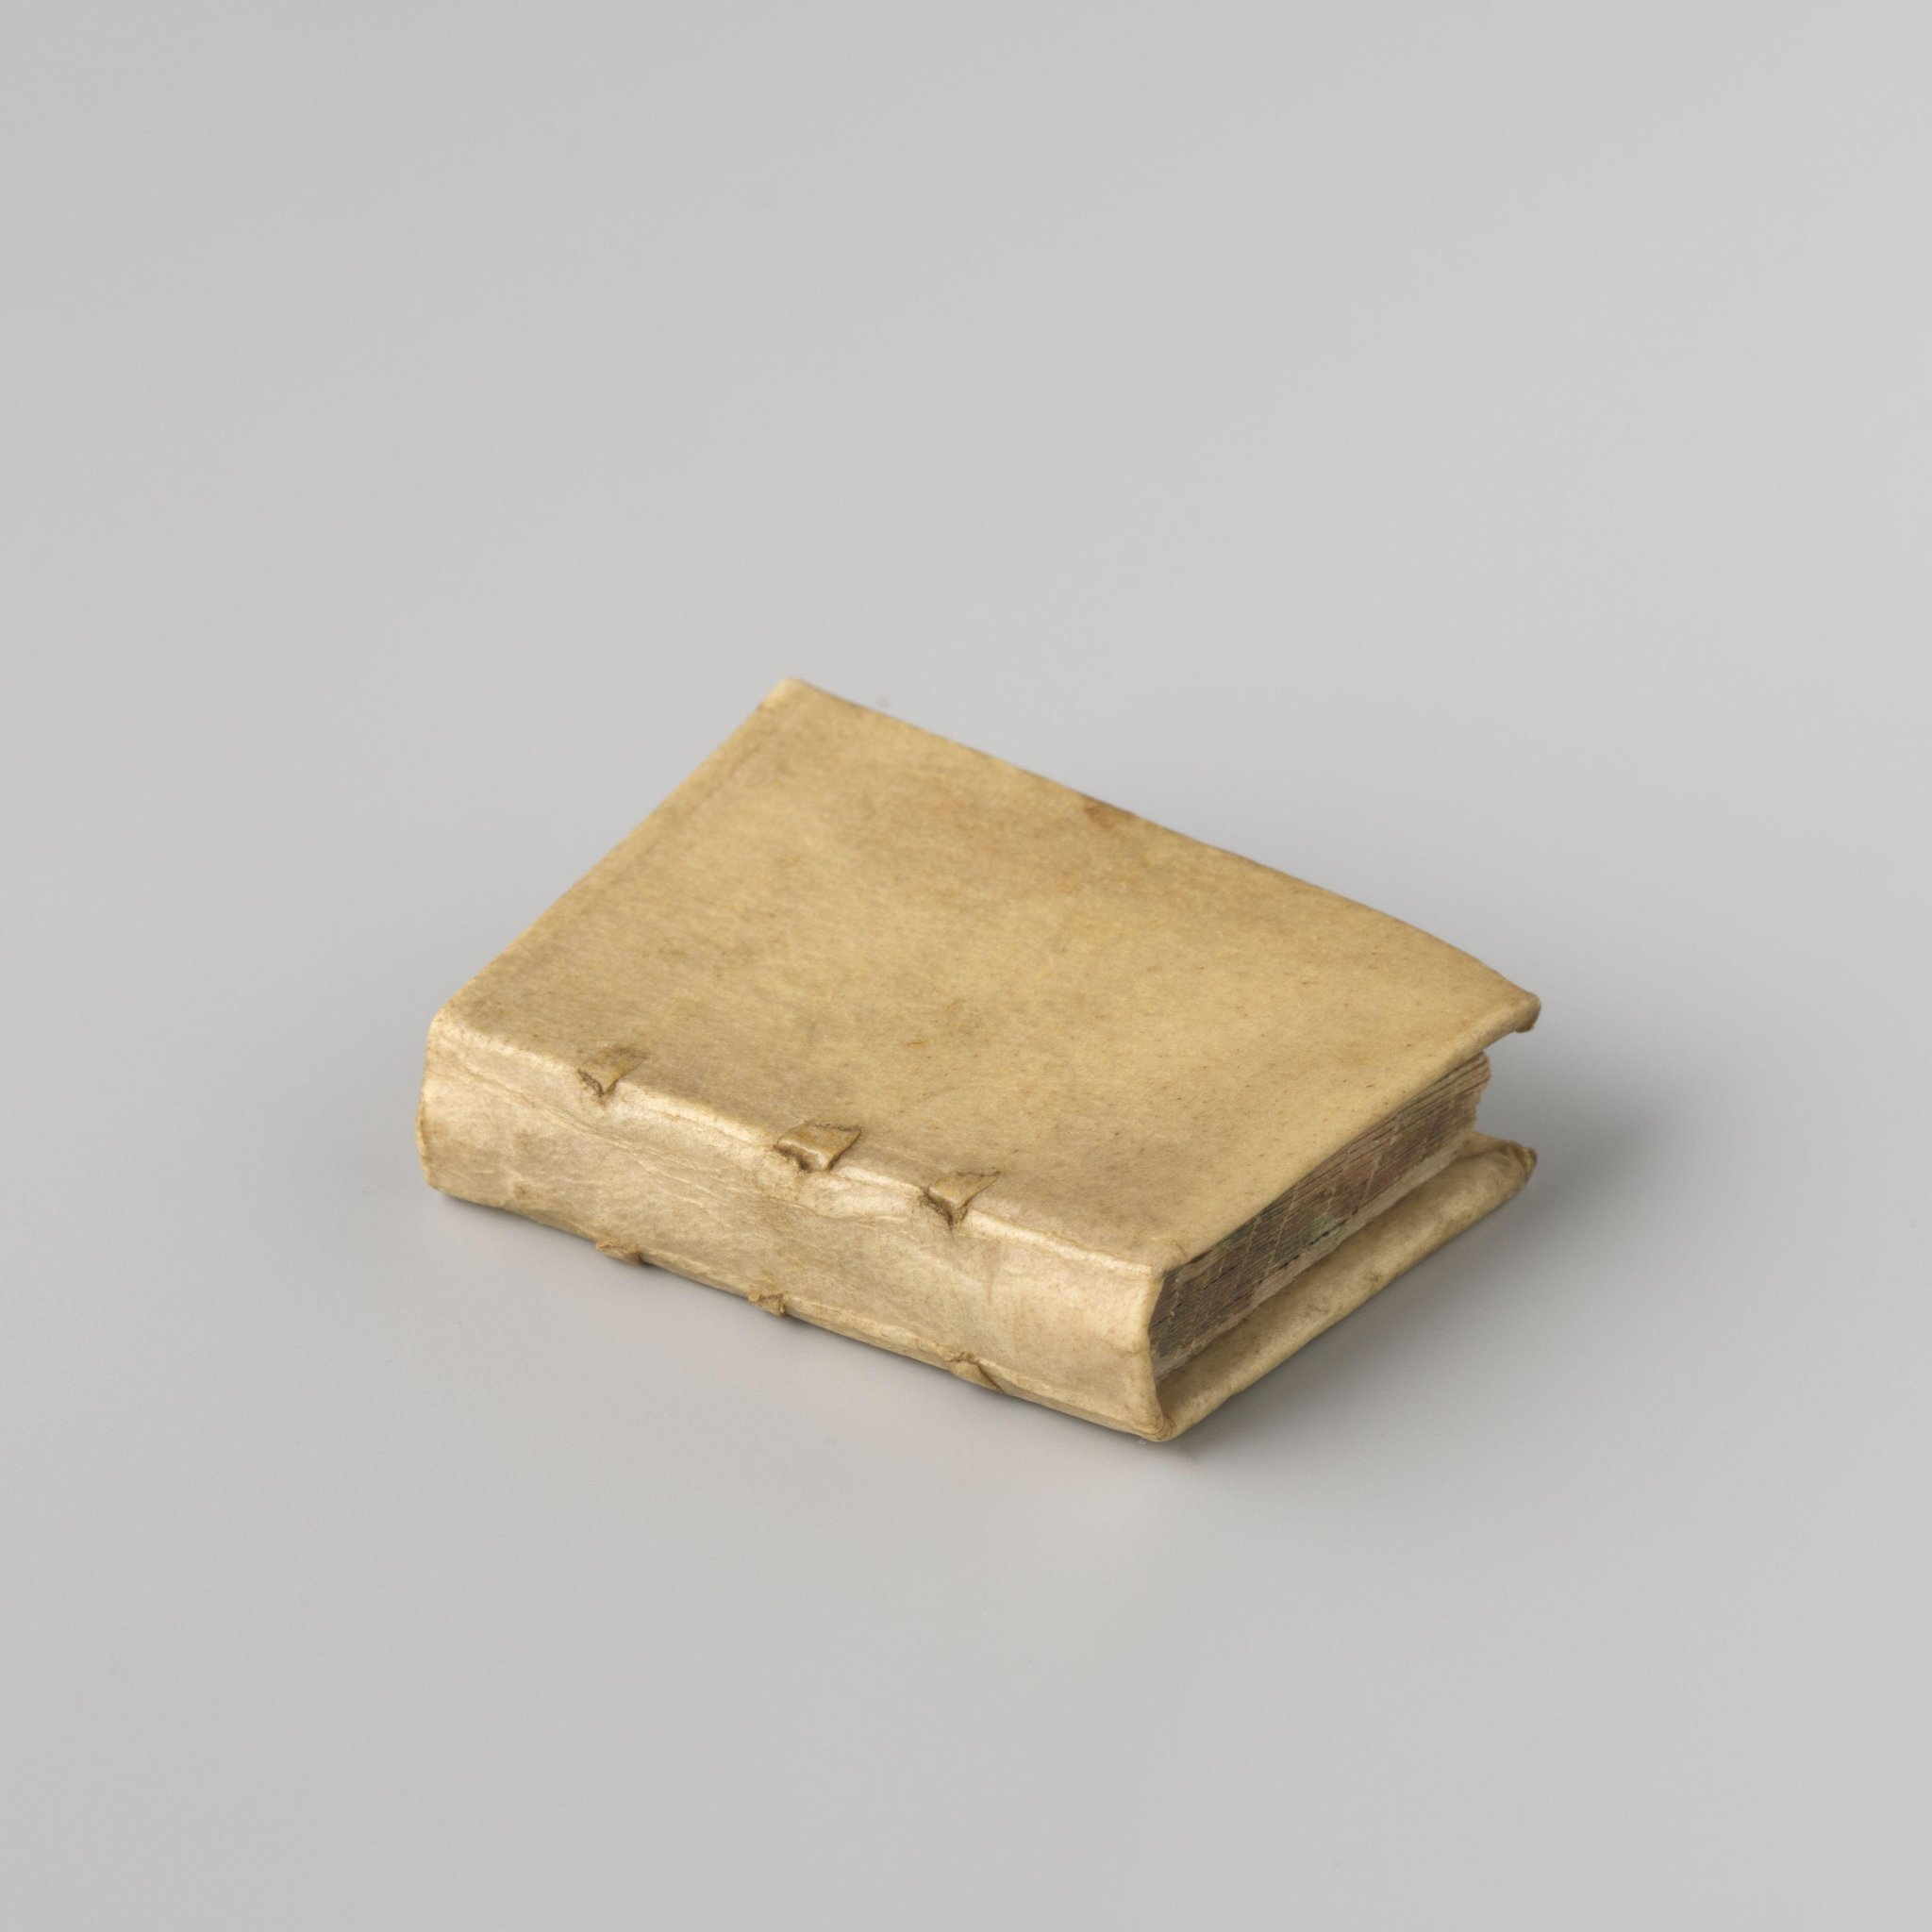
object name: miniature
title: Wapenboek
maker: jacobus robijn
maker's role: print maker, publisher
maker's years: -1707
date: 1673-1707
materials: paper, parchment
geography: amsterdam